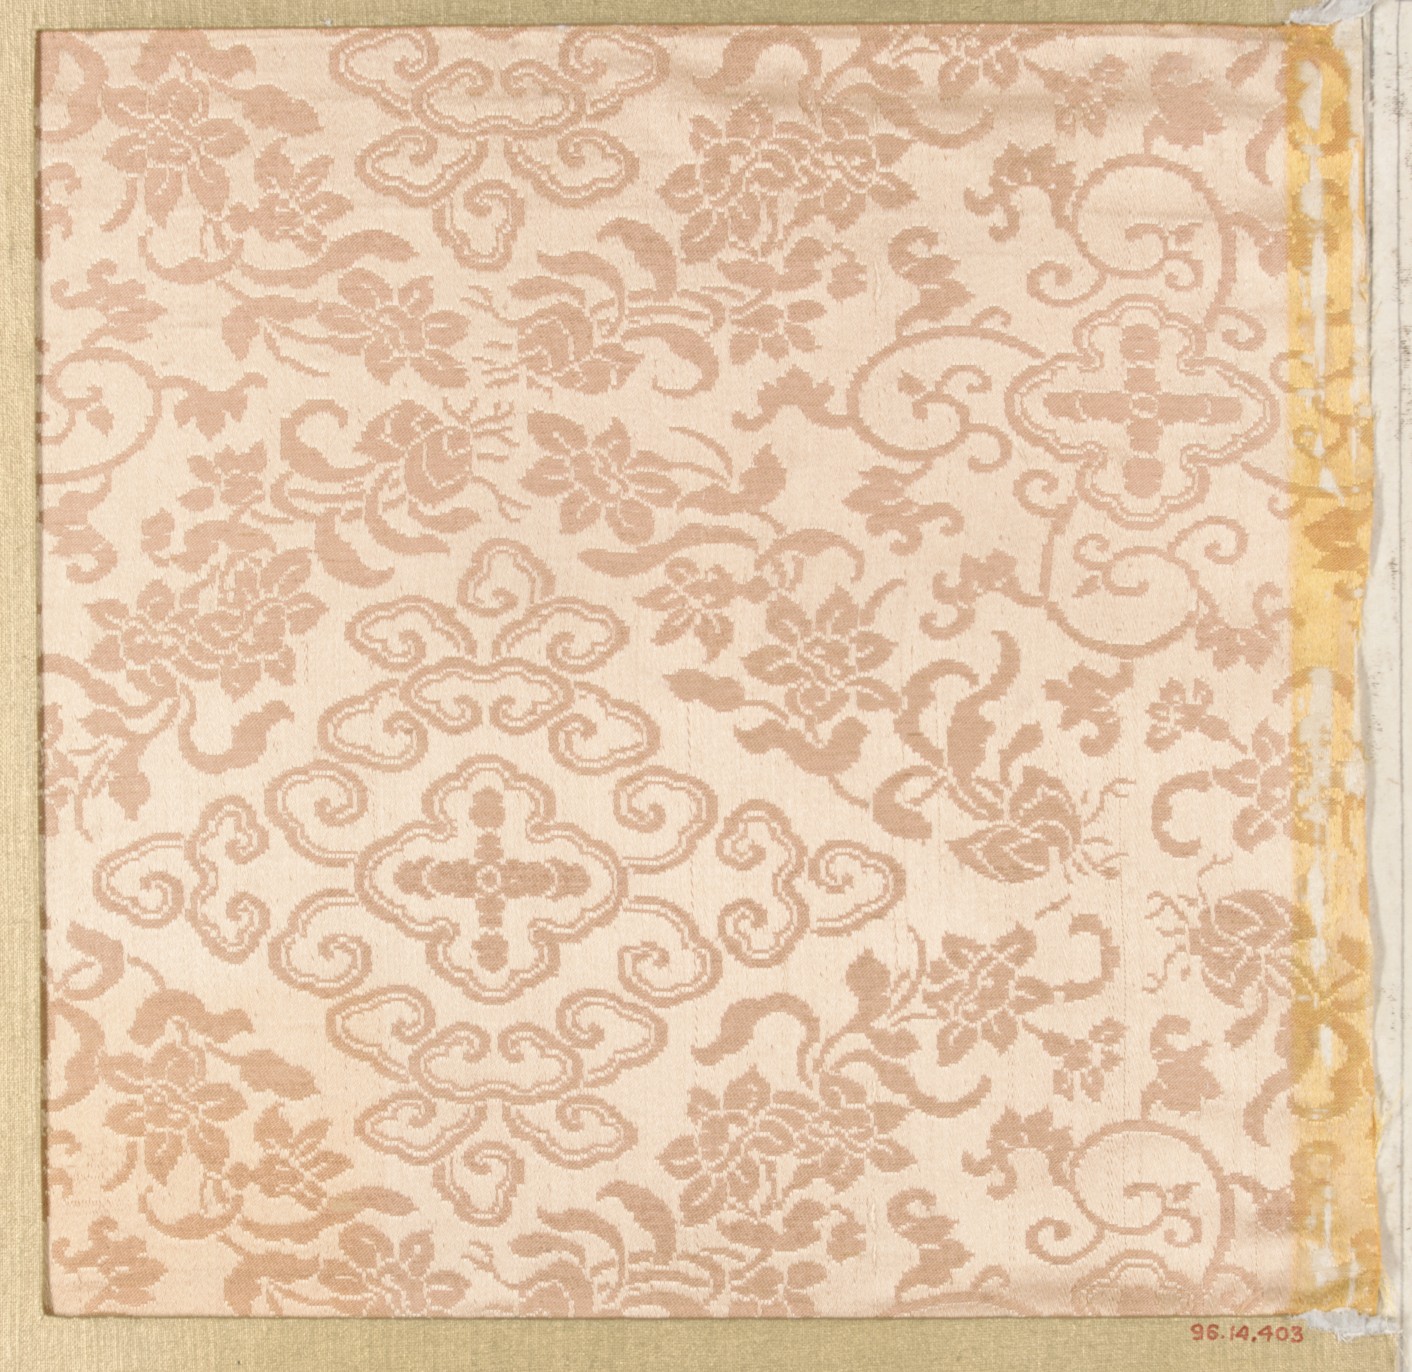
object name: piece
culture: japanese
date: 1701-1900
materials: silk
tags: leaves